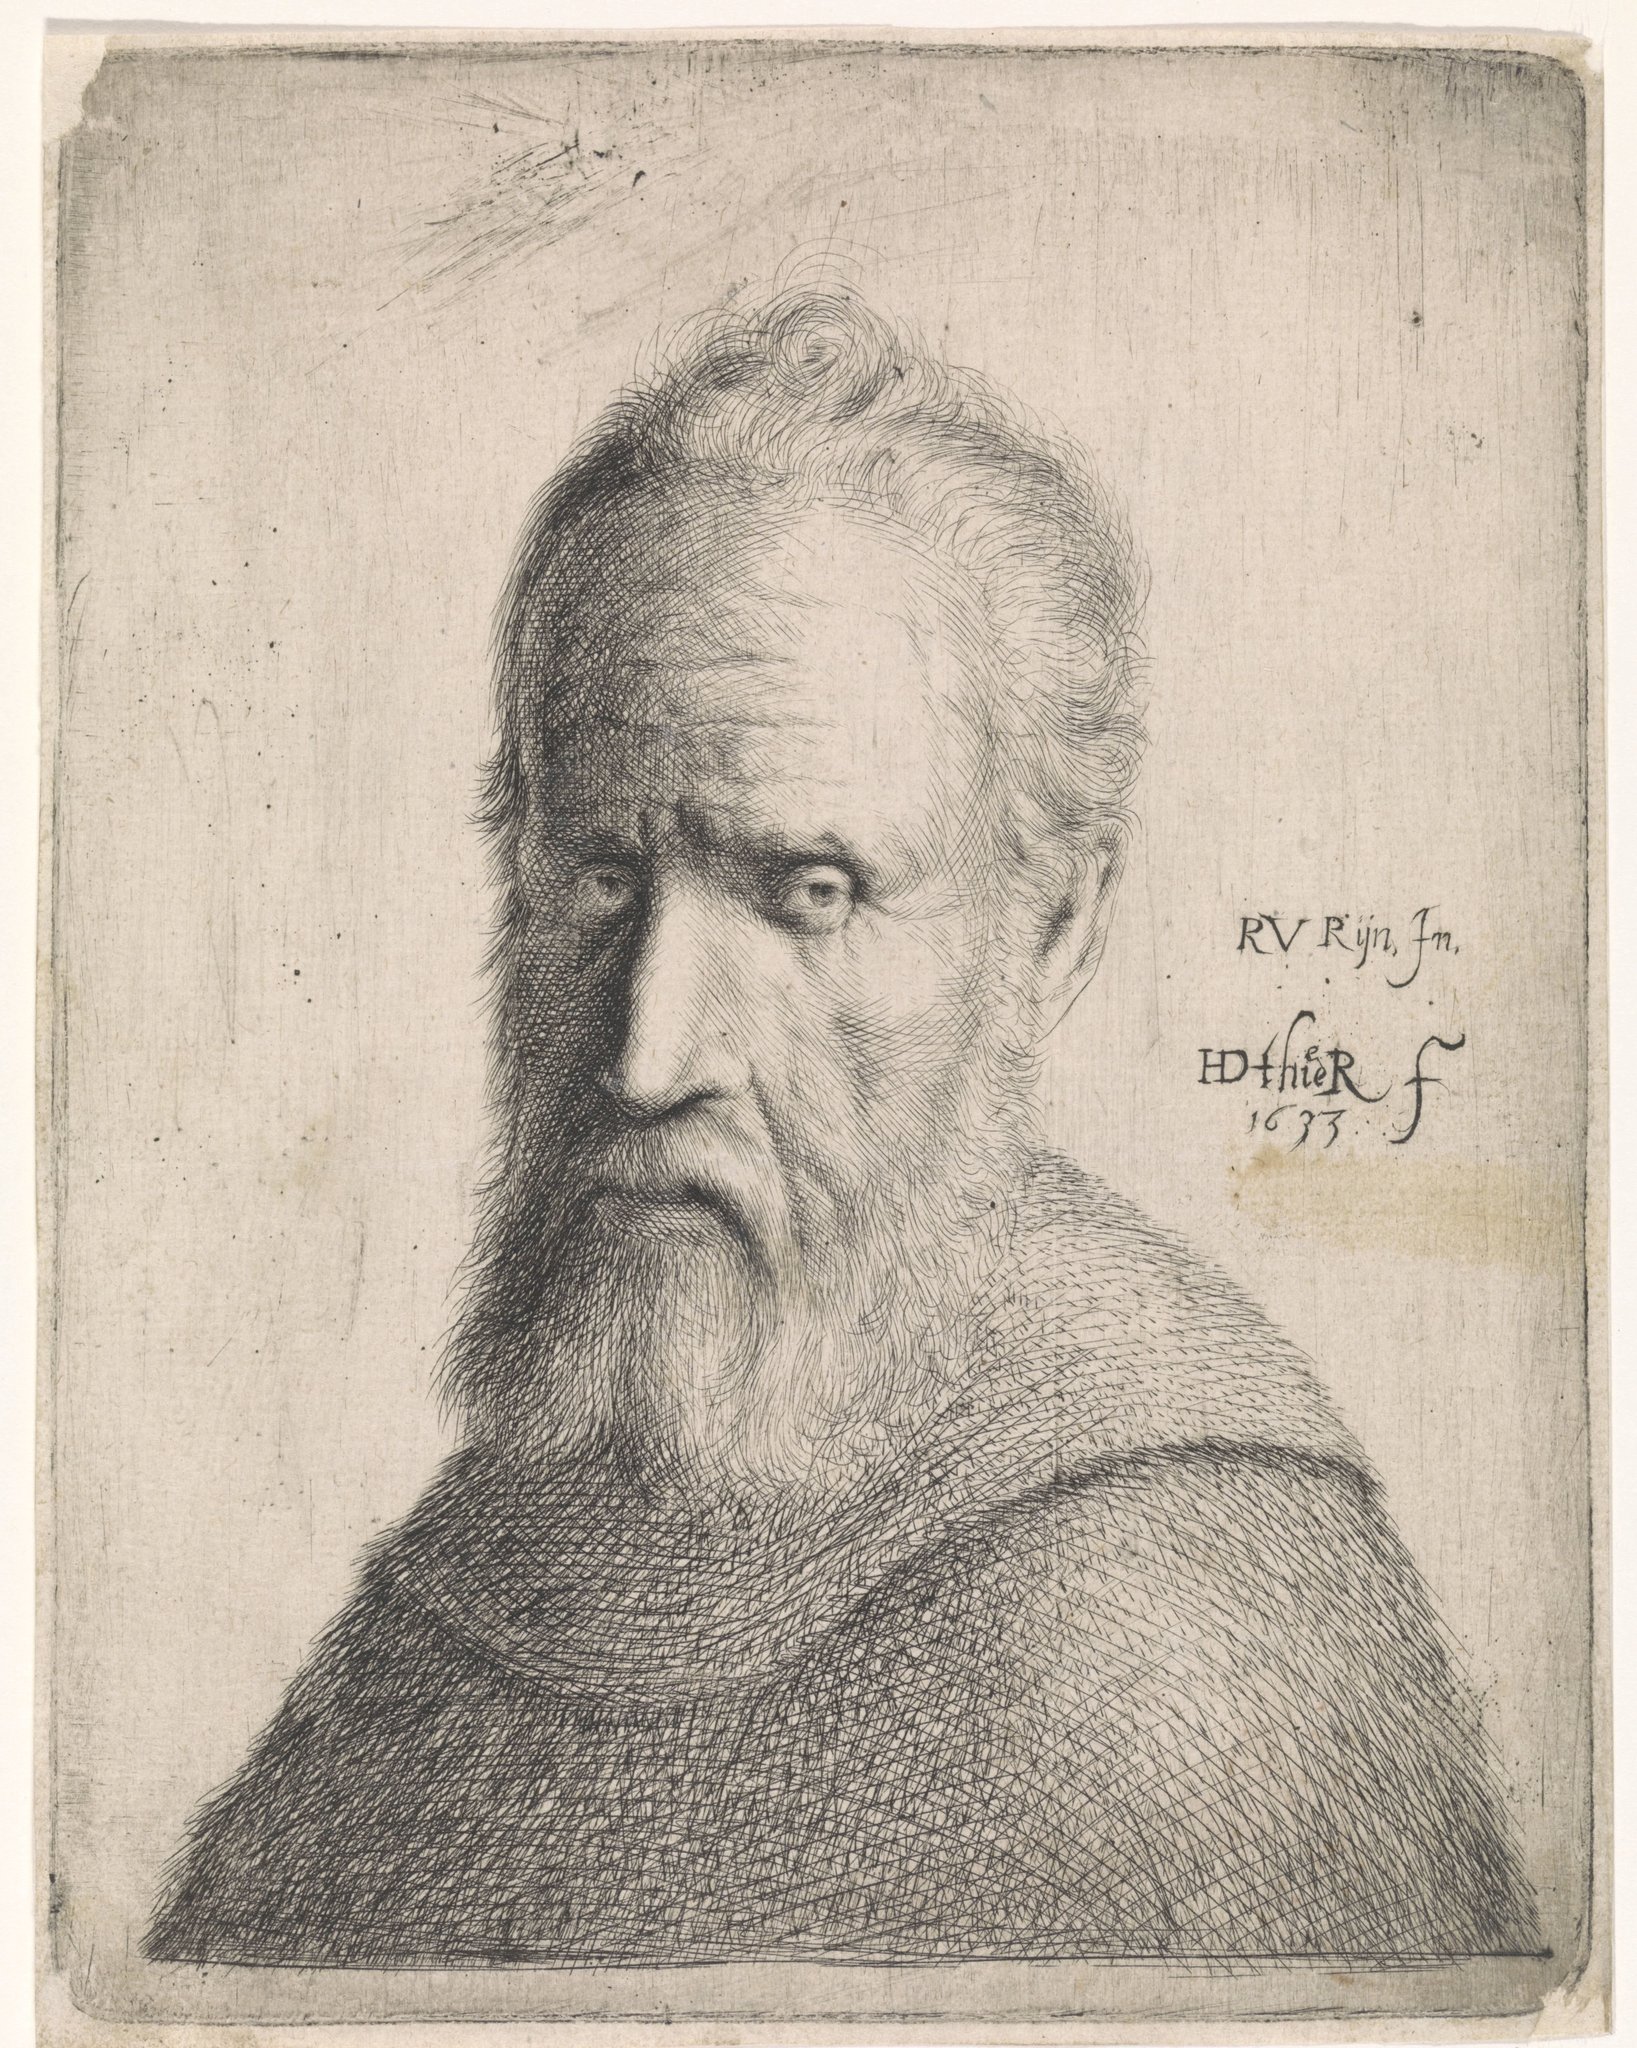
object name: print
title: Buste van een oude man met baard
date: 1633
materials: paper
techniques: etching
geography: netherlands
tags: old man, beard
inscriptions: collector's mark: Lugt 240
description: Buste van een oude man met baard naar links.